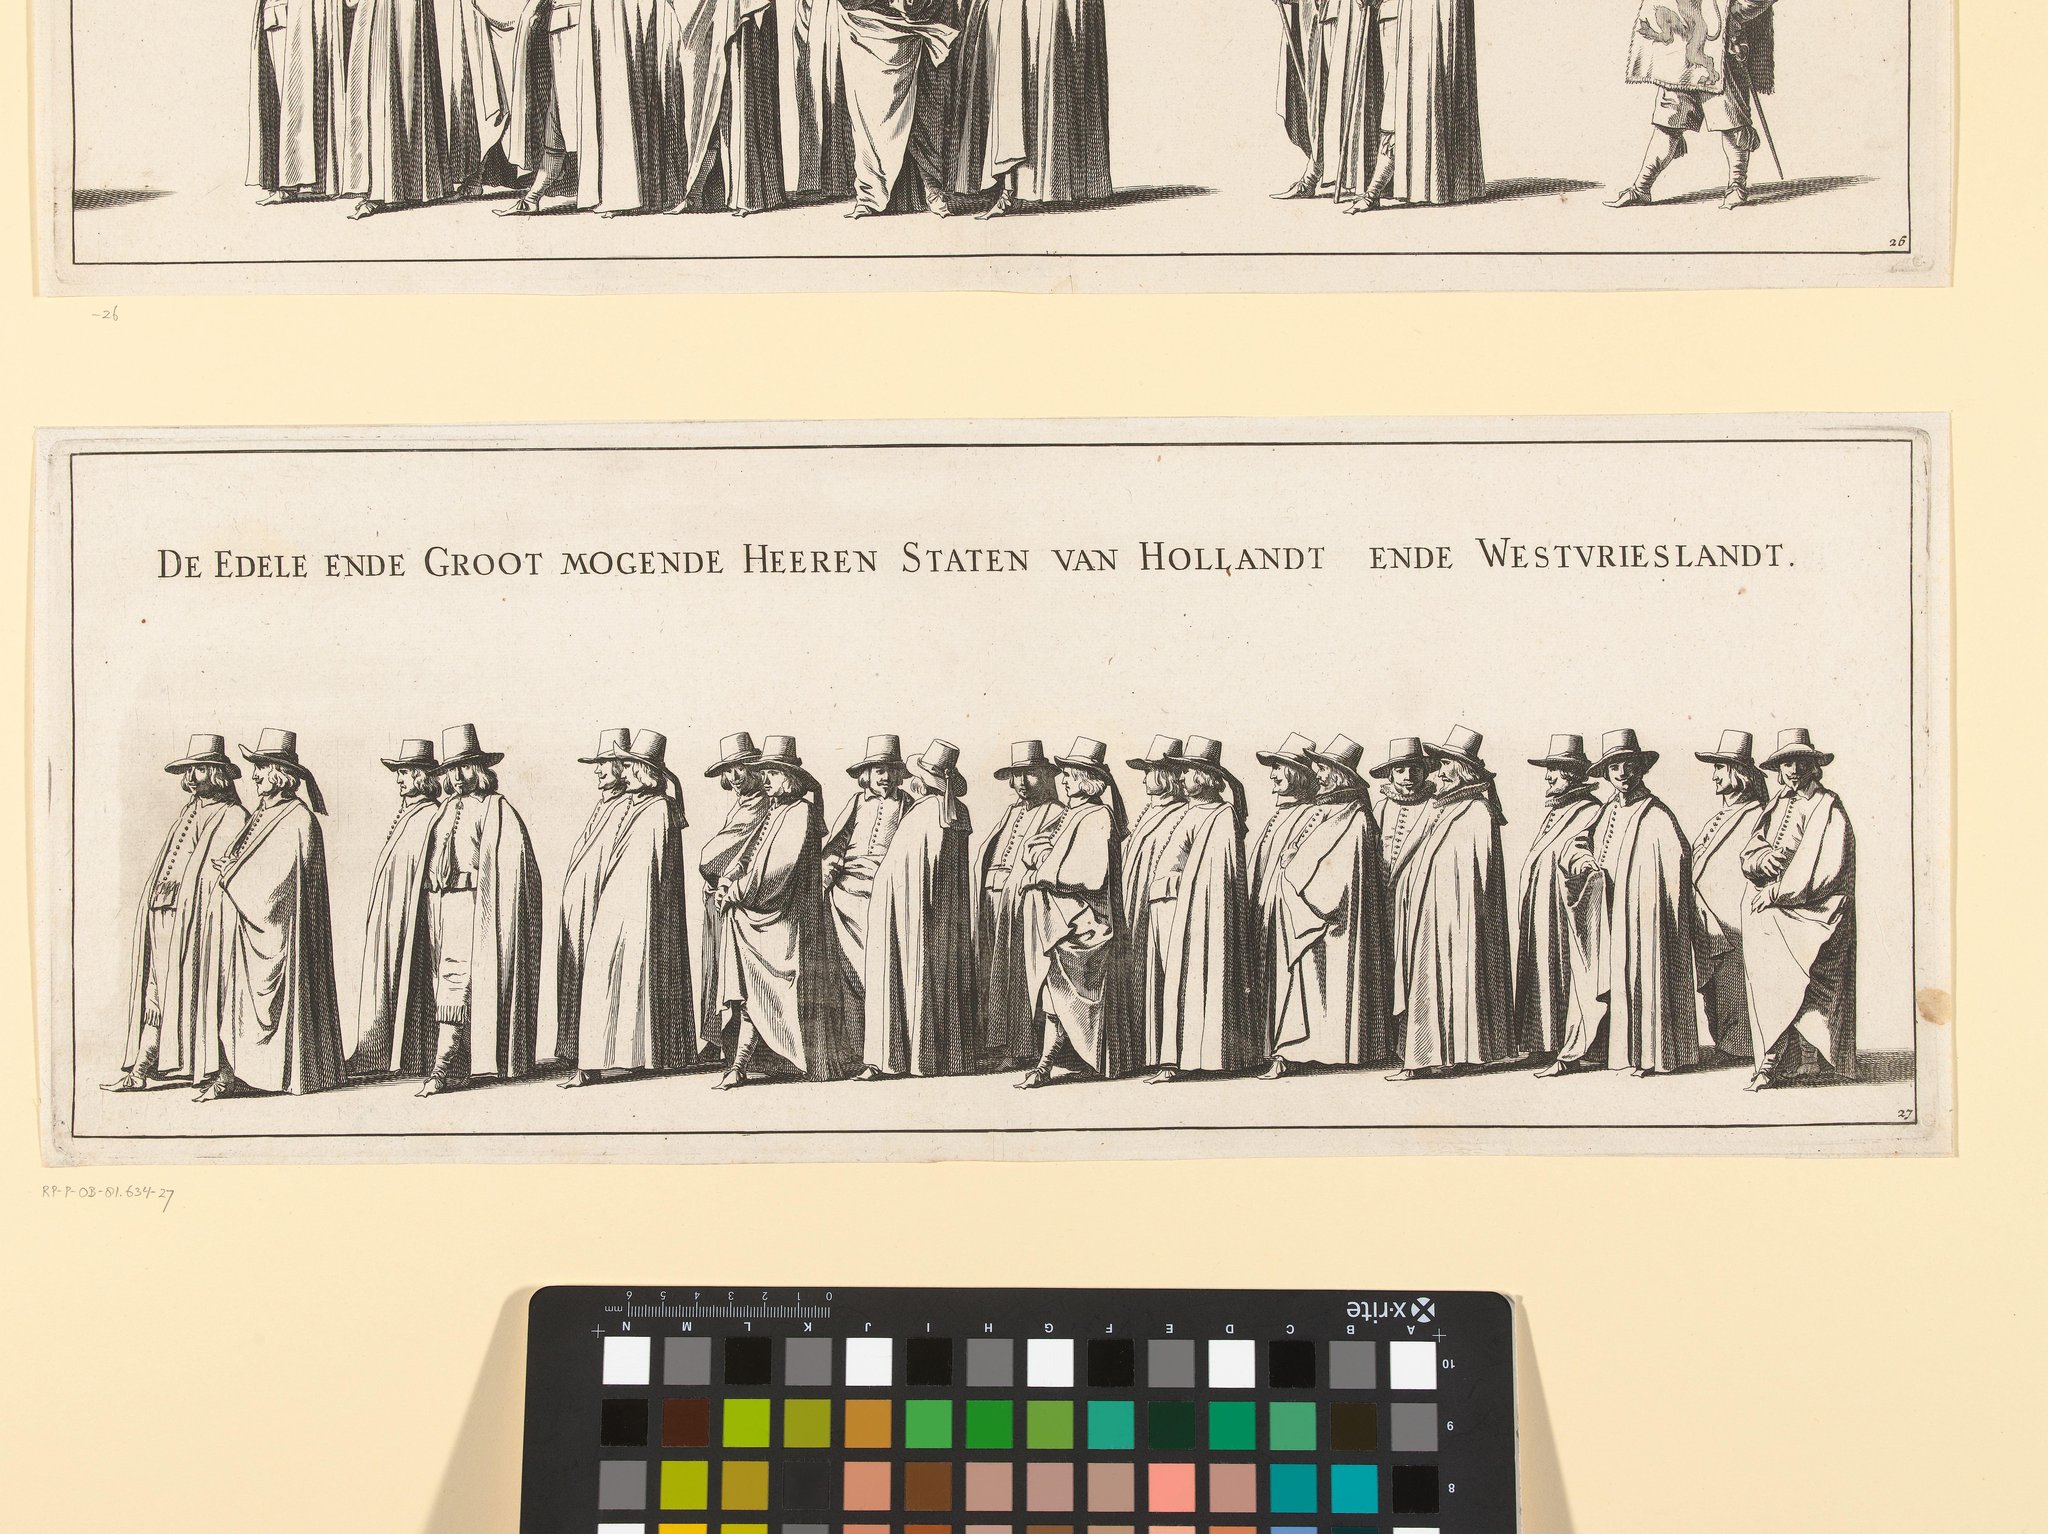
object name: print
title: Begraeffenisse van Syne Hoogheyt Frederick Henrick, by der Gratien Gods Prince van Orange, Grave van Nassau &c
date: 1647-1651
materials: paper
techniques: etching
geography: amsterdam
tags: the hague, frederick henry (prince of orange), cortege, funeral procession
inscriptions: collector's mark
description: De begrafenisstoet van stadhouder Frederik Hendrik te 's-Gravenhage op 10 mei 1647. Plaat nr. 27 met een deel van de stoet met leden van de Staten van Holland en West-Friesland, boven de personen staat hun functie. Onderdeel van een serie van 30 platen en 20 tekstbladen, bedoeld om aan elkaar geplakt te worden.